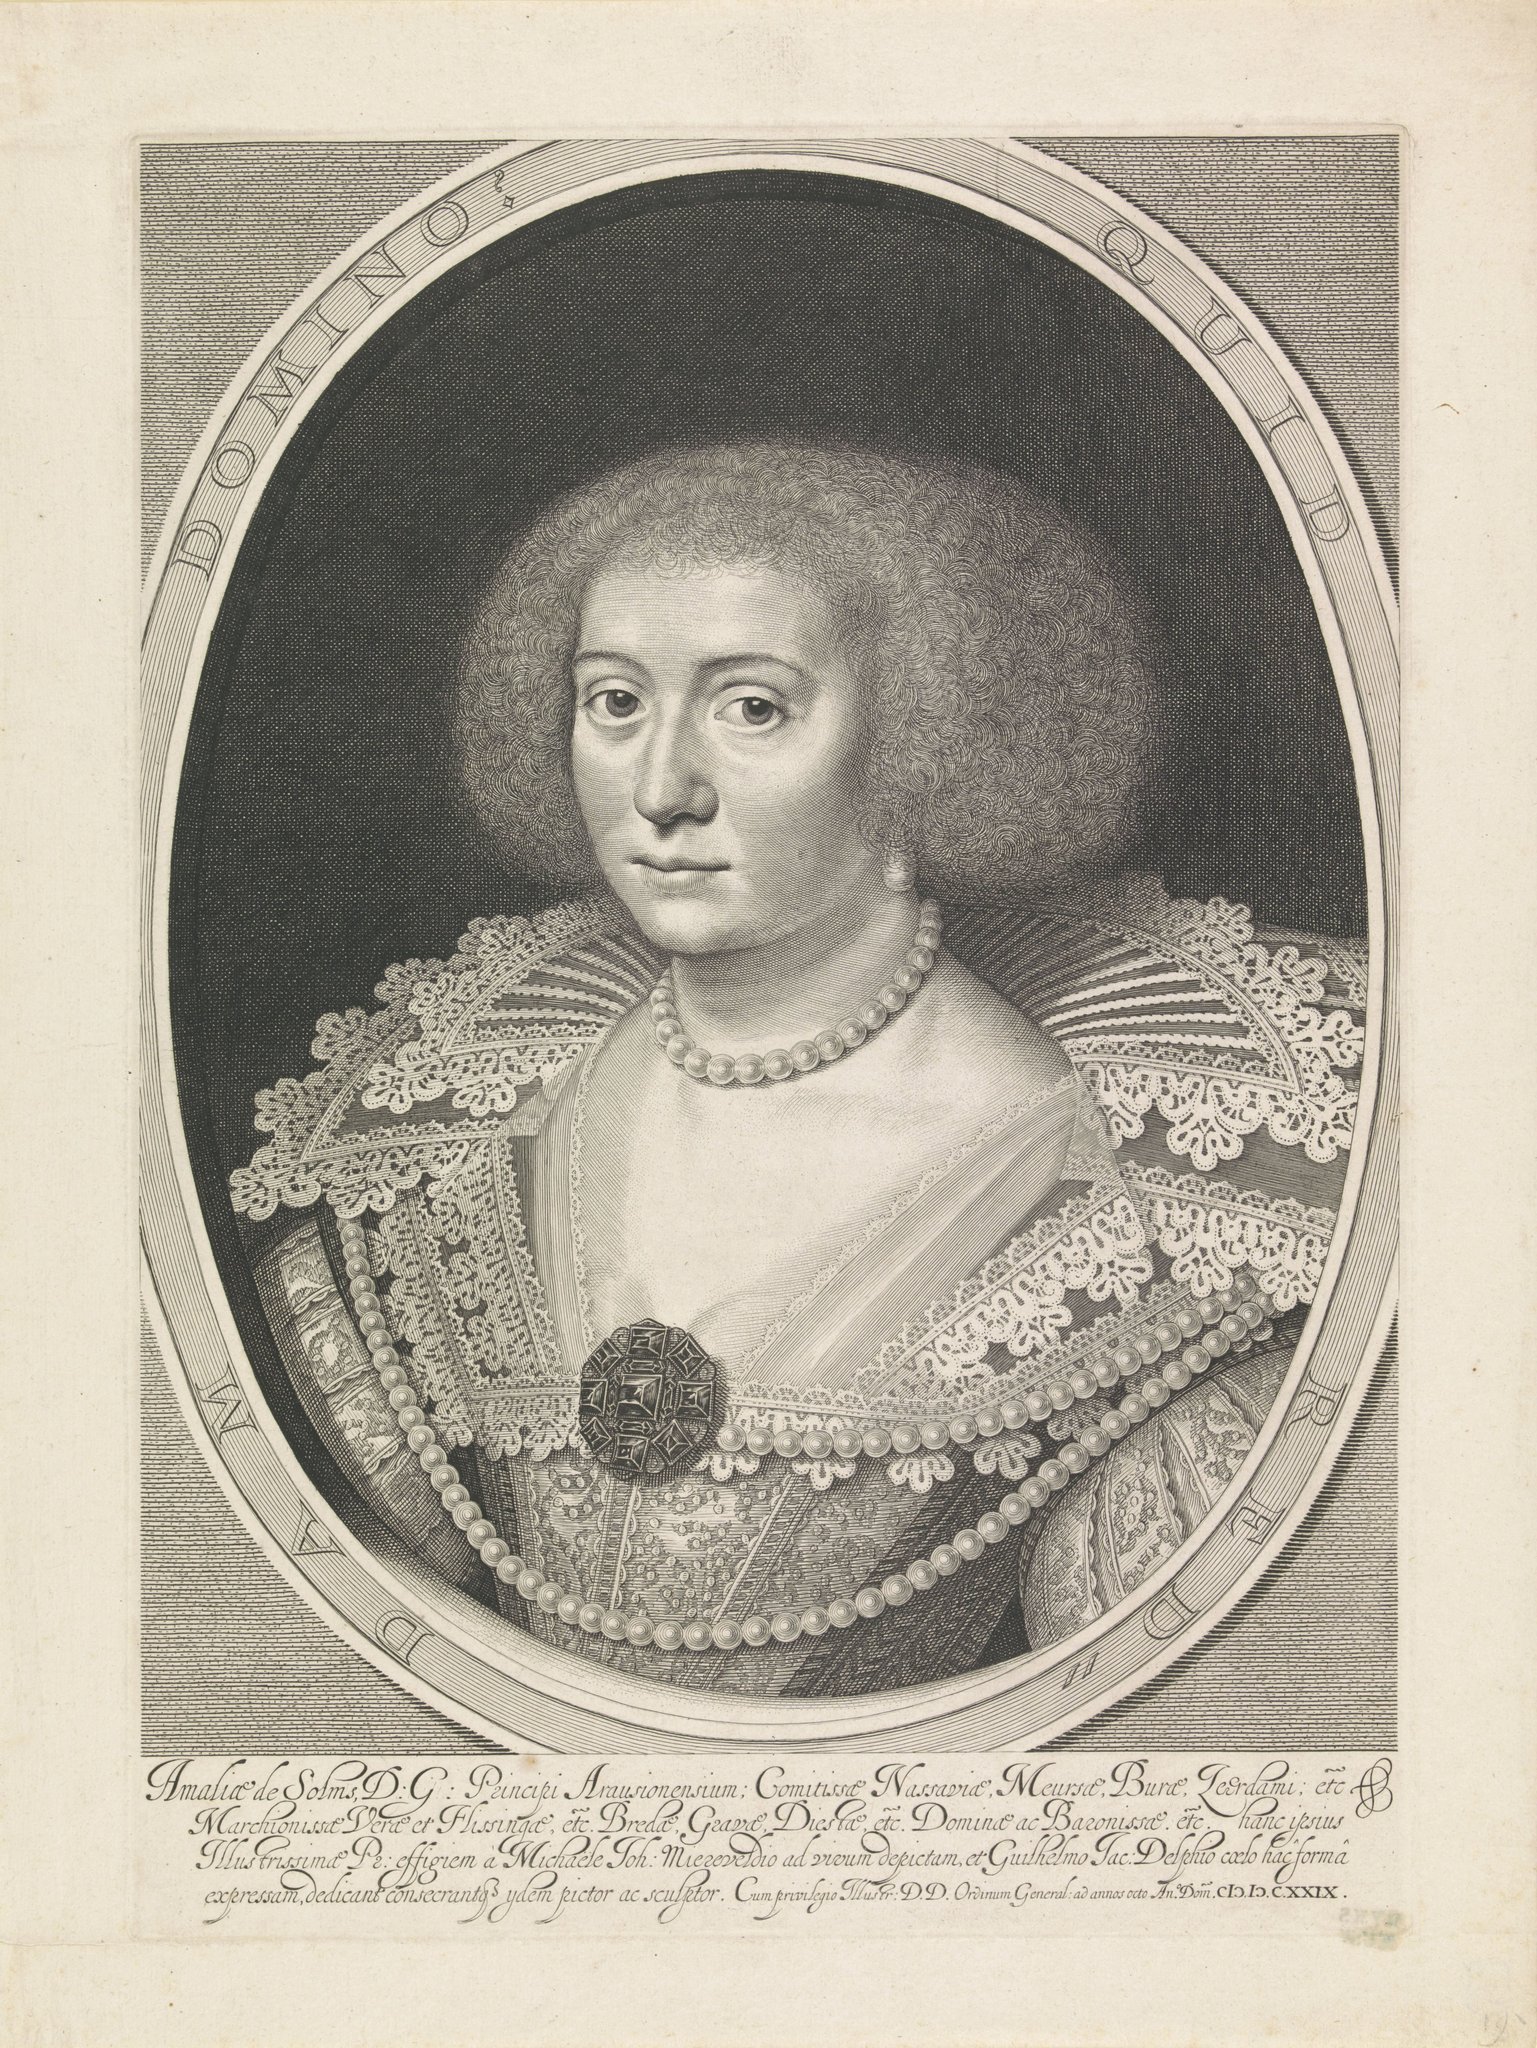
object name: print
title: Portret van Amalia van Solms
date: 1629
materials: paper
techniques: engraving, etching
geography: delft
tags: the hague, amalia of solms-braunfels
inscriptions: collector's mark: Lugt 963, collector's mark: Lugt 2165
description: Portret van Amalia in een ovaal met randschrift. In de ondermarge vier regels Latijnse tekst.